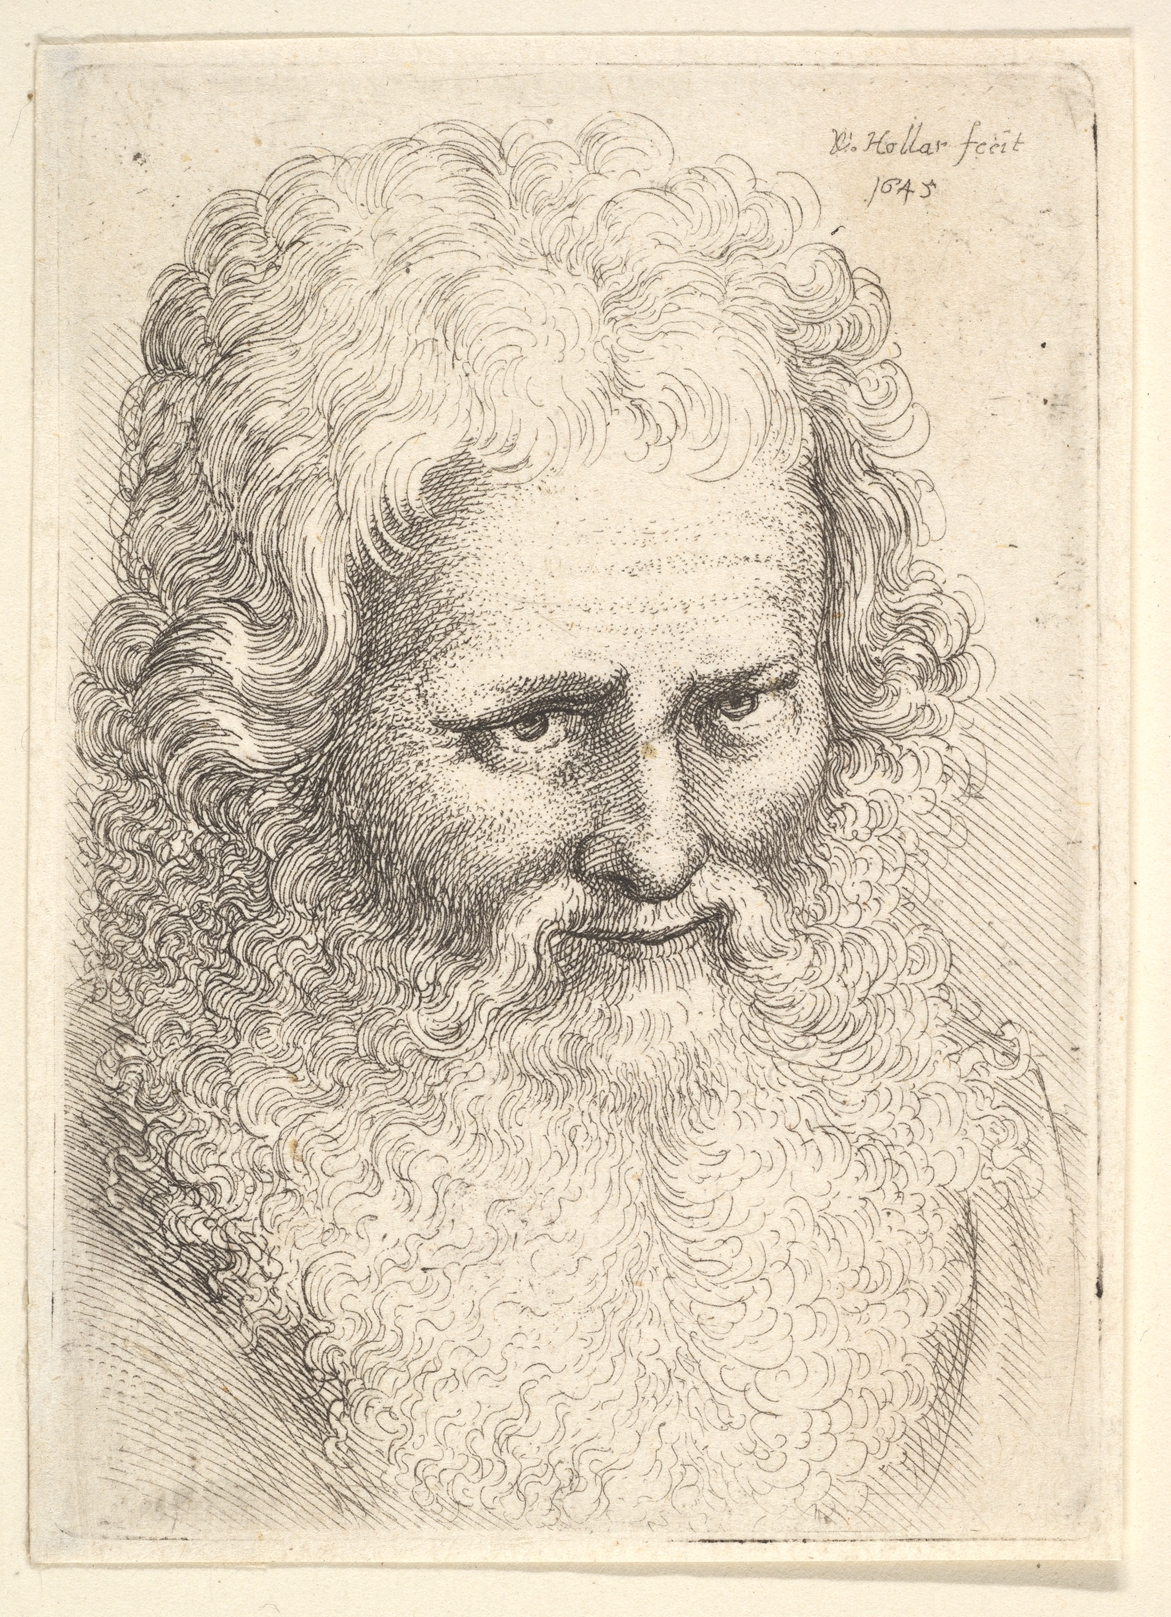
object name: print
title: Head of an old man with a large beard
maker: wenceslaus hollar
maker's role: artist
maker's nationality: bohemian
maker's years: 1607-1677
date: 1645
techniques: etching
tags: heads,men,portraits